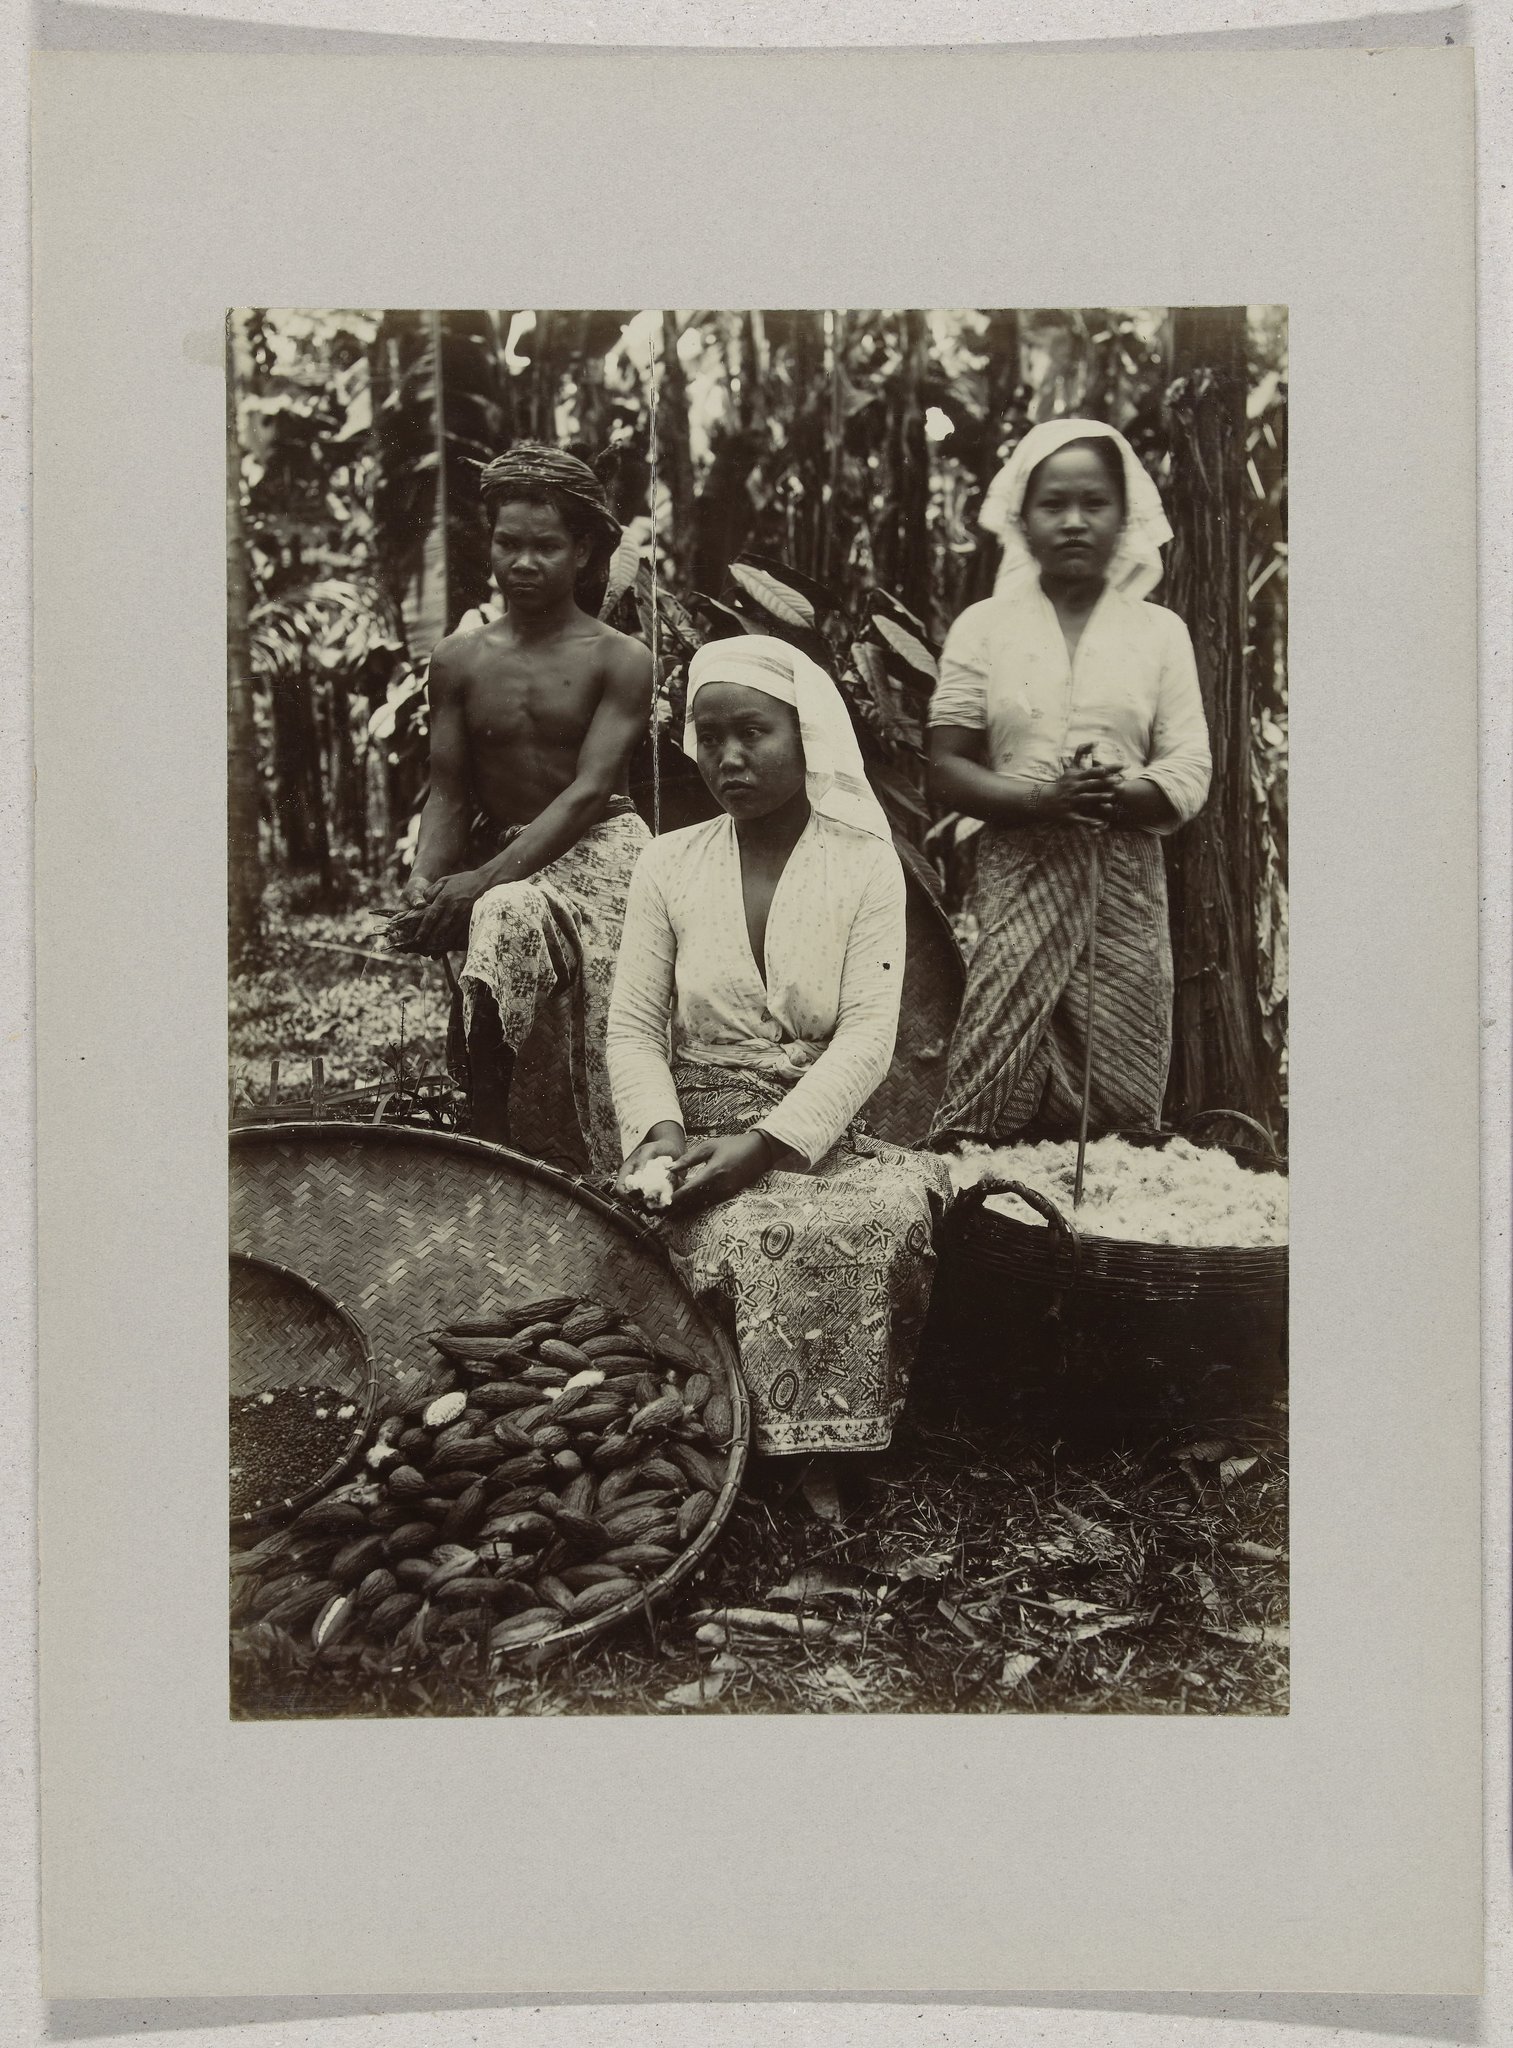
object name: photograph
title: Plukkers van kapok op een plantage op Java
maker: Anonymous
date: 1895-1915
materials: cardboard, paper, photographic support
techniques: gelatin silver print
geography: java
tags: indonesia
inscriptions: number: ‘25’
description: Vergelijk KITLV fotonr. 2562: Javareis van A.E.F. Muntz van maart 1901 tot juli 1902